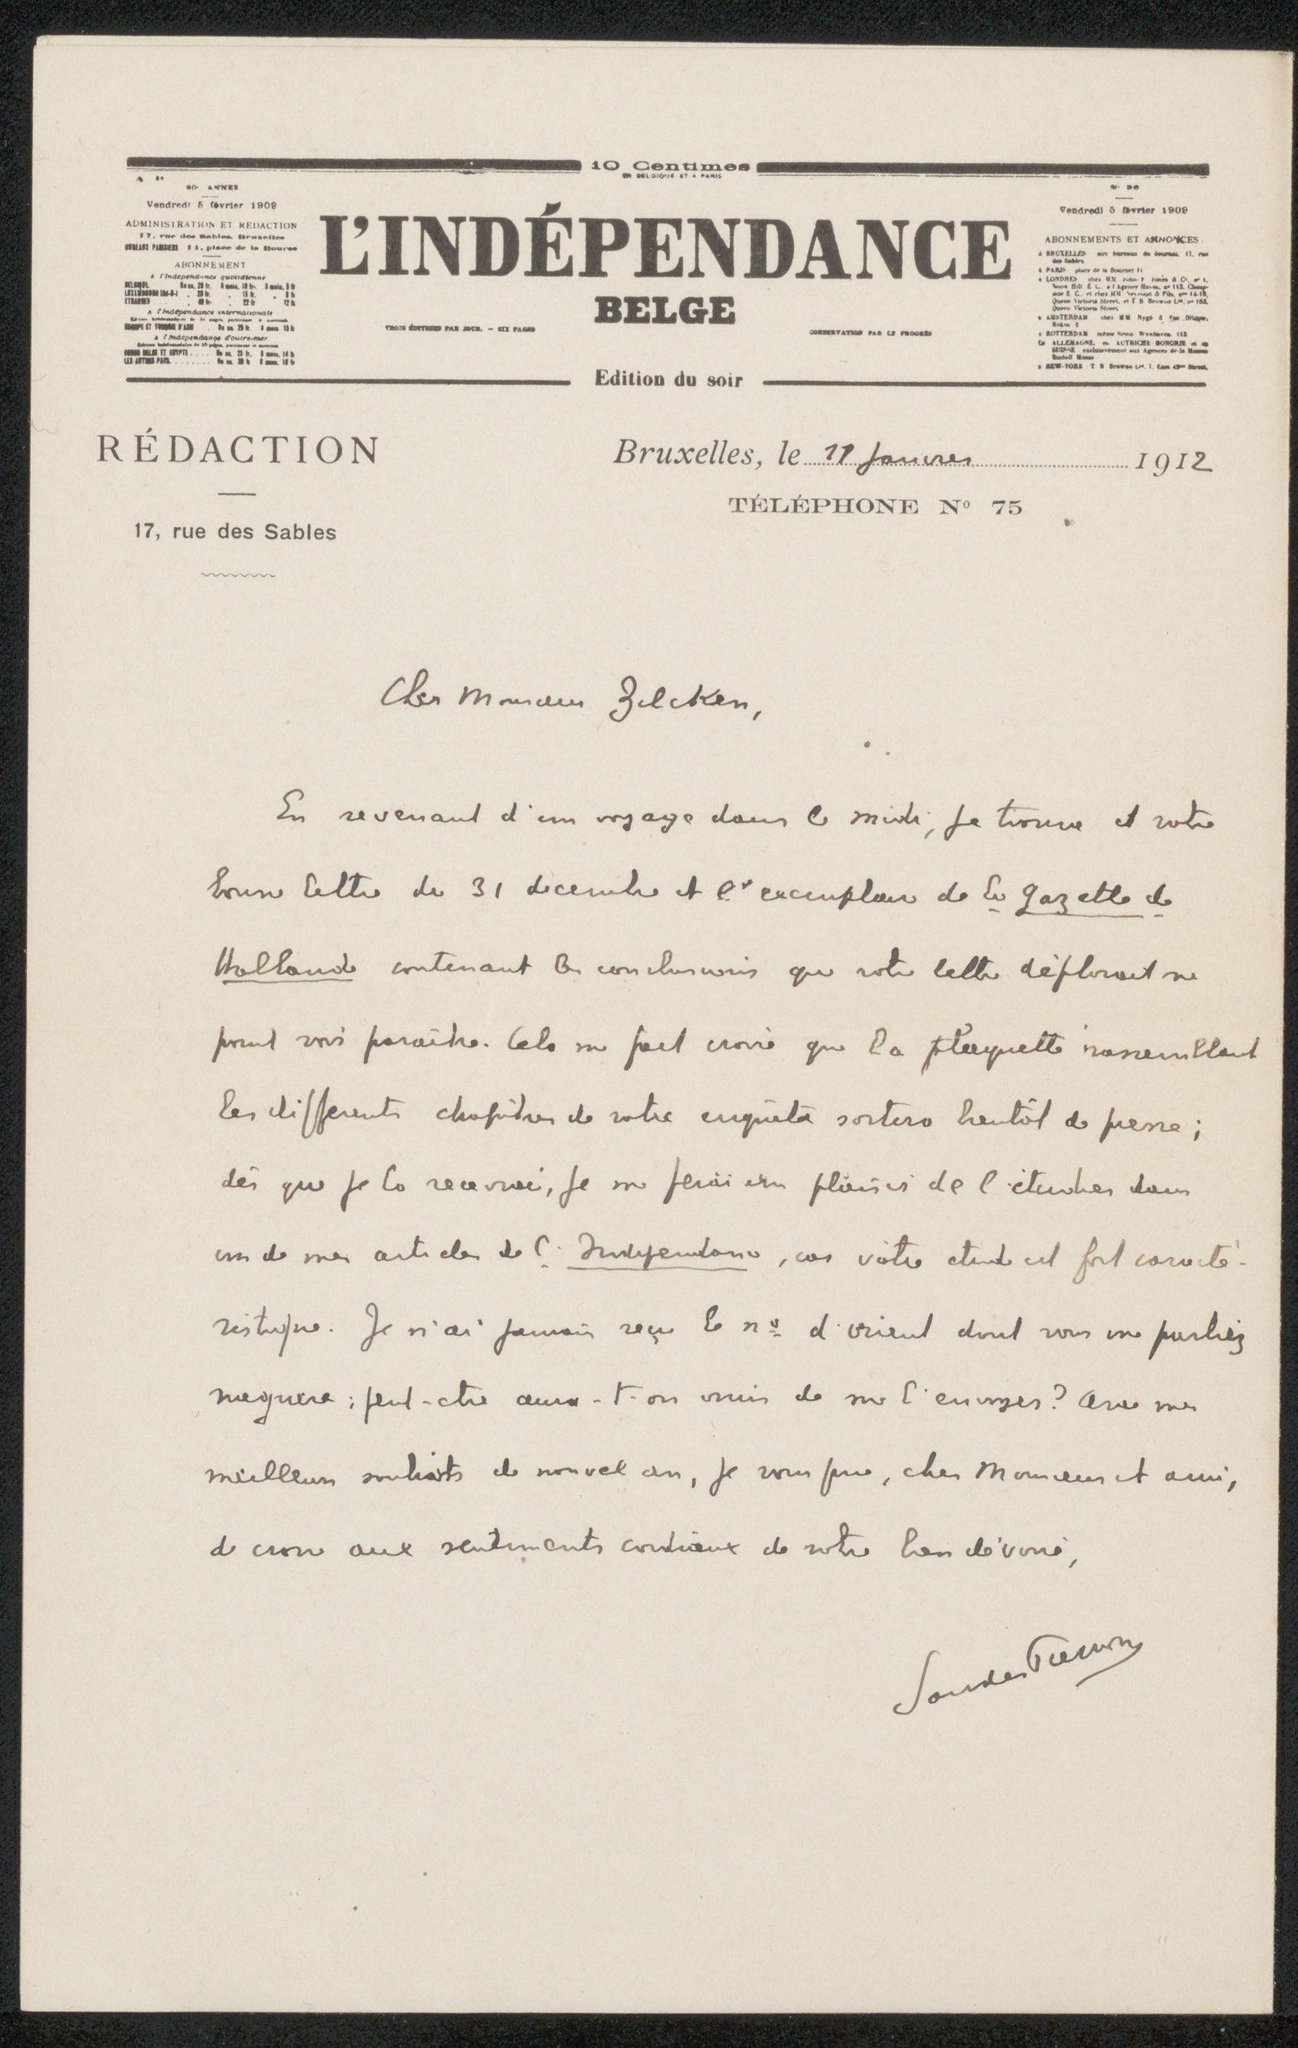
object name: letter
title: Brief aan Philip Zilcken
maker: sander pierron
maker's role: schrijver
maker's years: 1872-1945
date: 1912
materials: ink, paper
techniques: pen, printing, writing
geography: elsene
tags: the hague, painter, philip zilcken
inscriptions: collector's mark: ‘RPK’